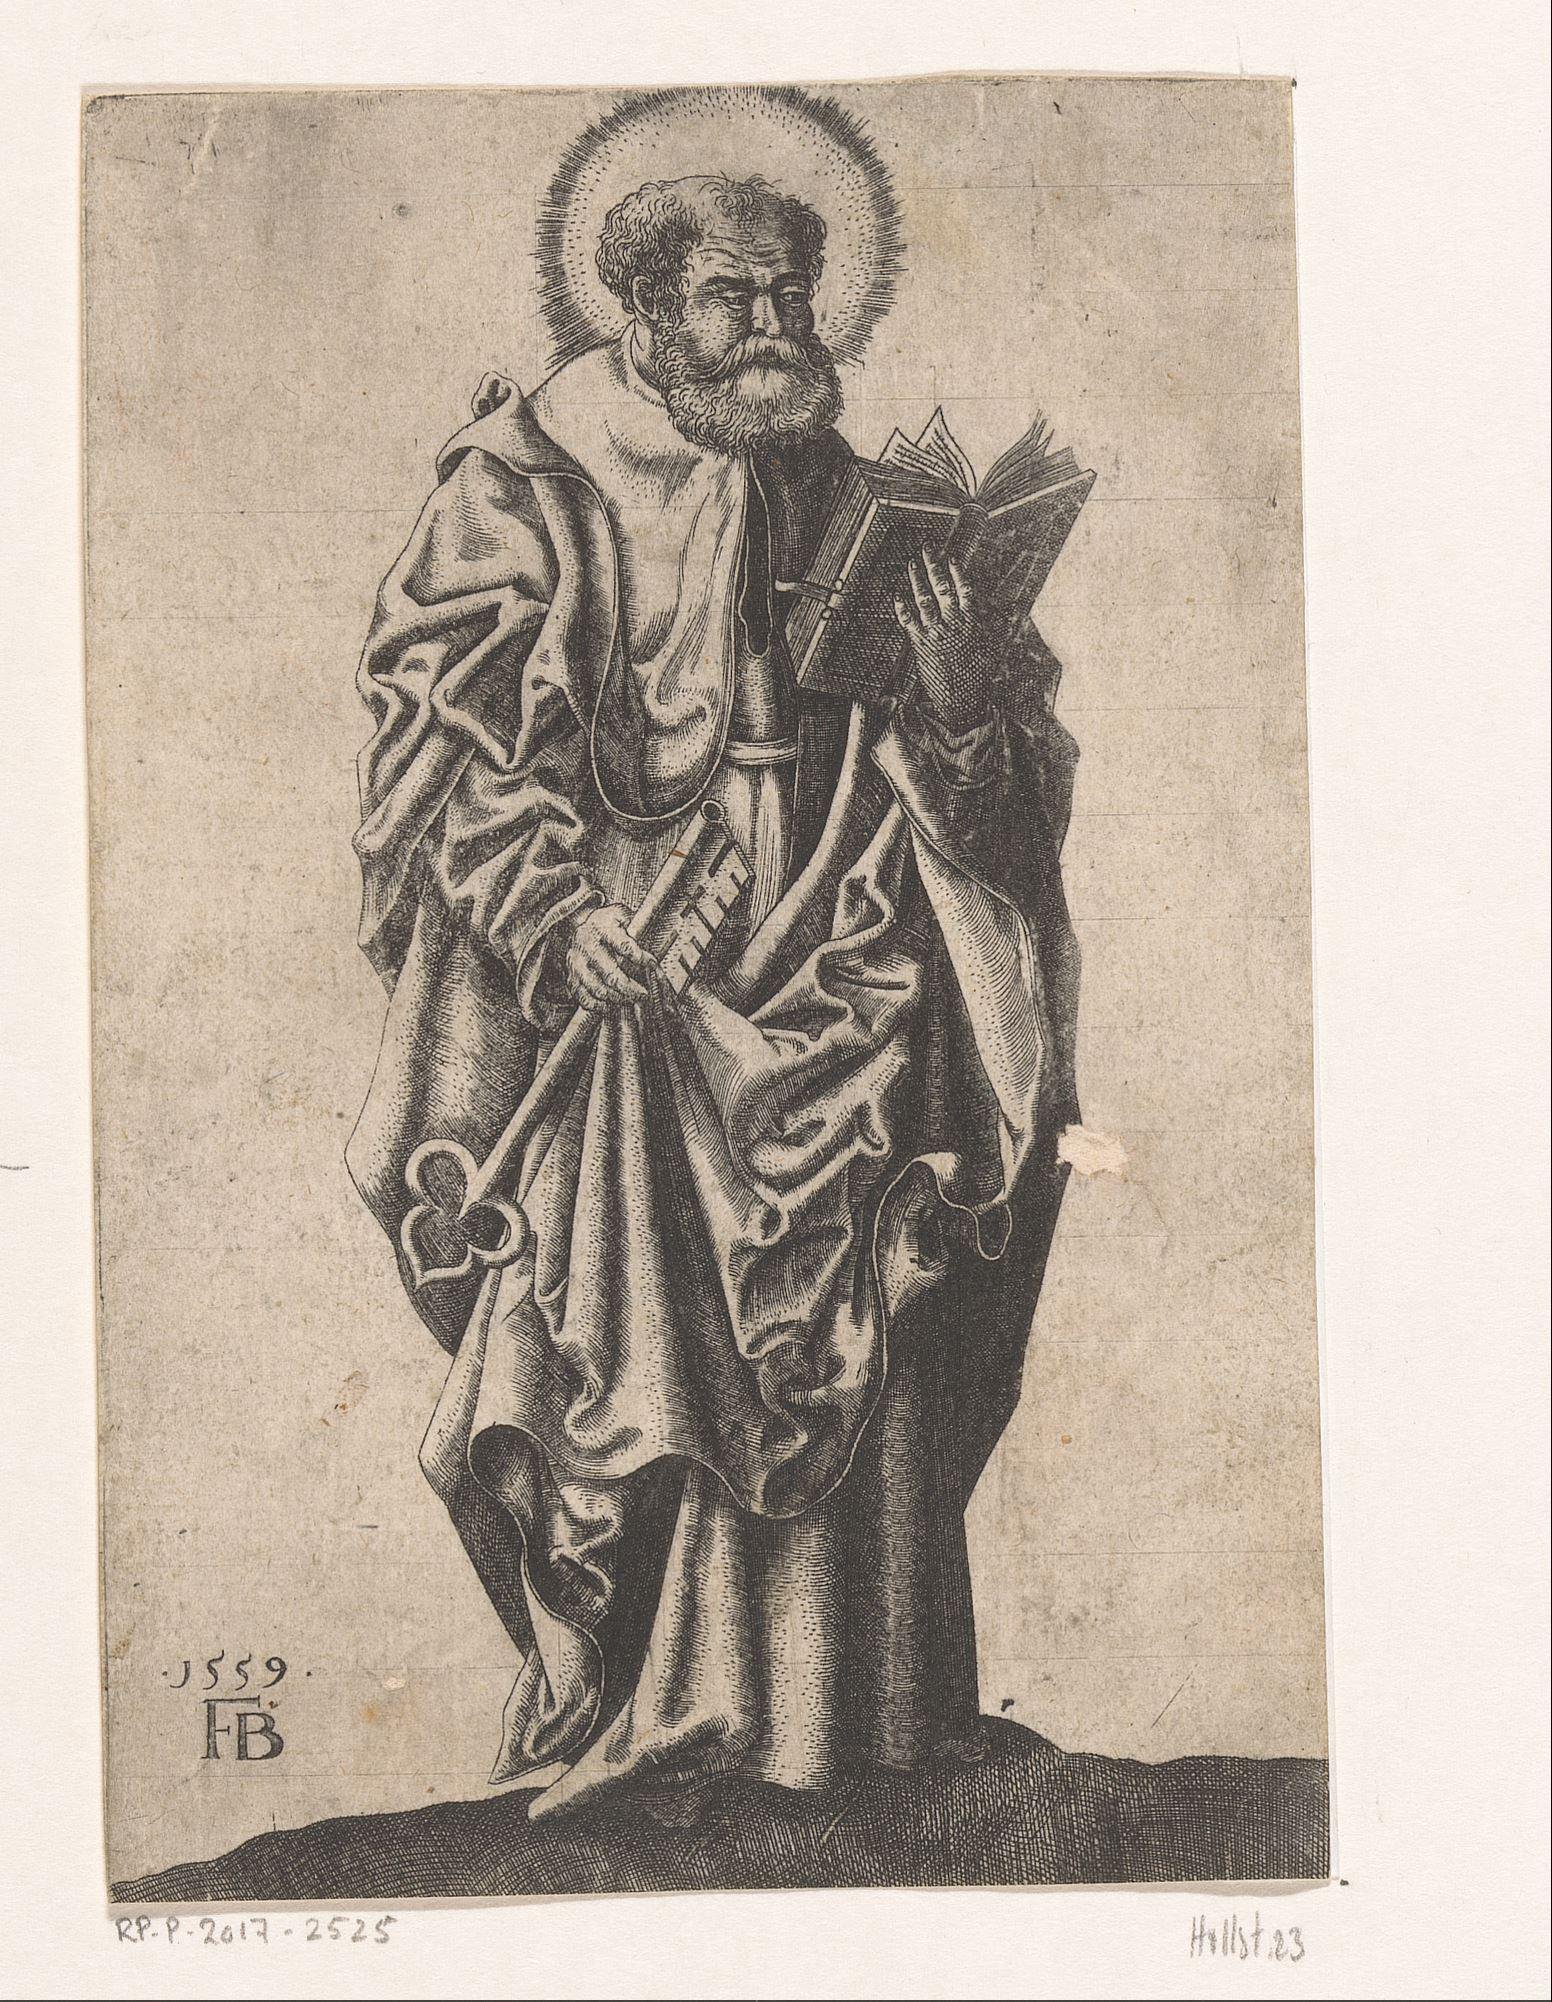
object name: print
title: Heilige Petrus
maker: franz isaac brun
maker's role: print maker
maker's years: 1535-1620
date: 1559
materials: paper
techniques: engraving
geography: germany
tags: the apostle peter, first bishop of rome; possible attributes: book, cock, (upturned) cross, (triple) crozier, fish, key, scroll, ship, tiara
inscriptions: collector's mark: Lugt 2228